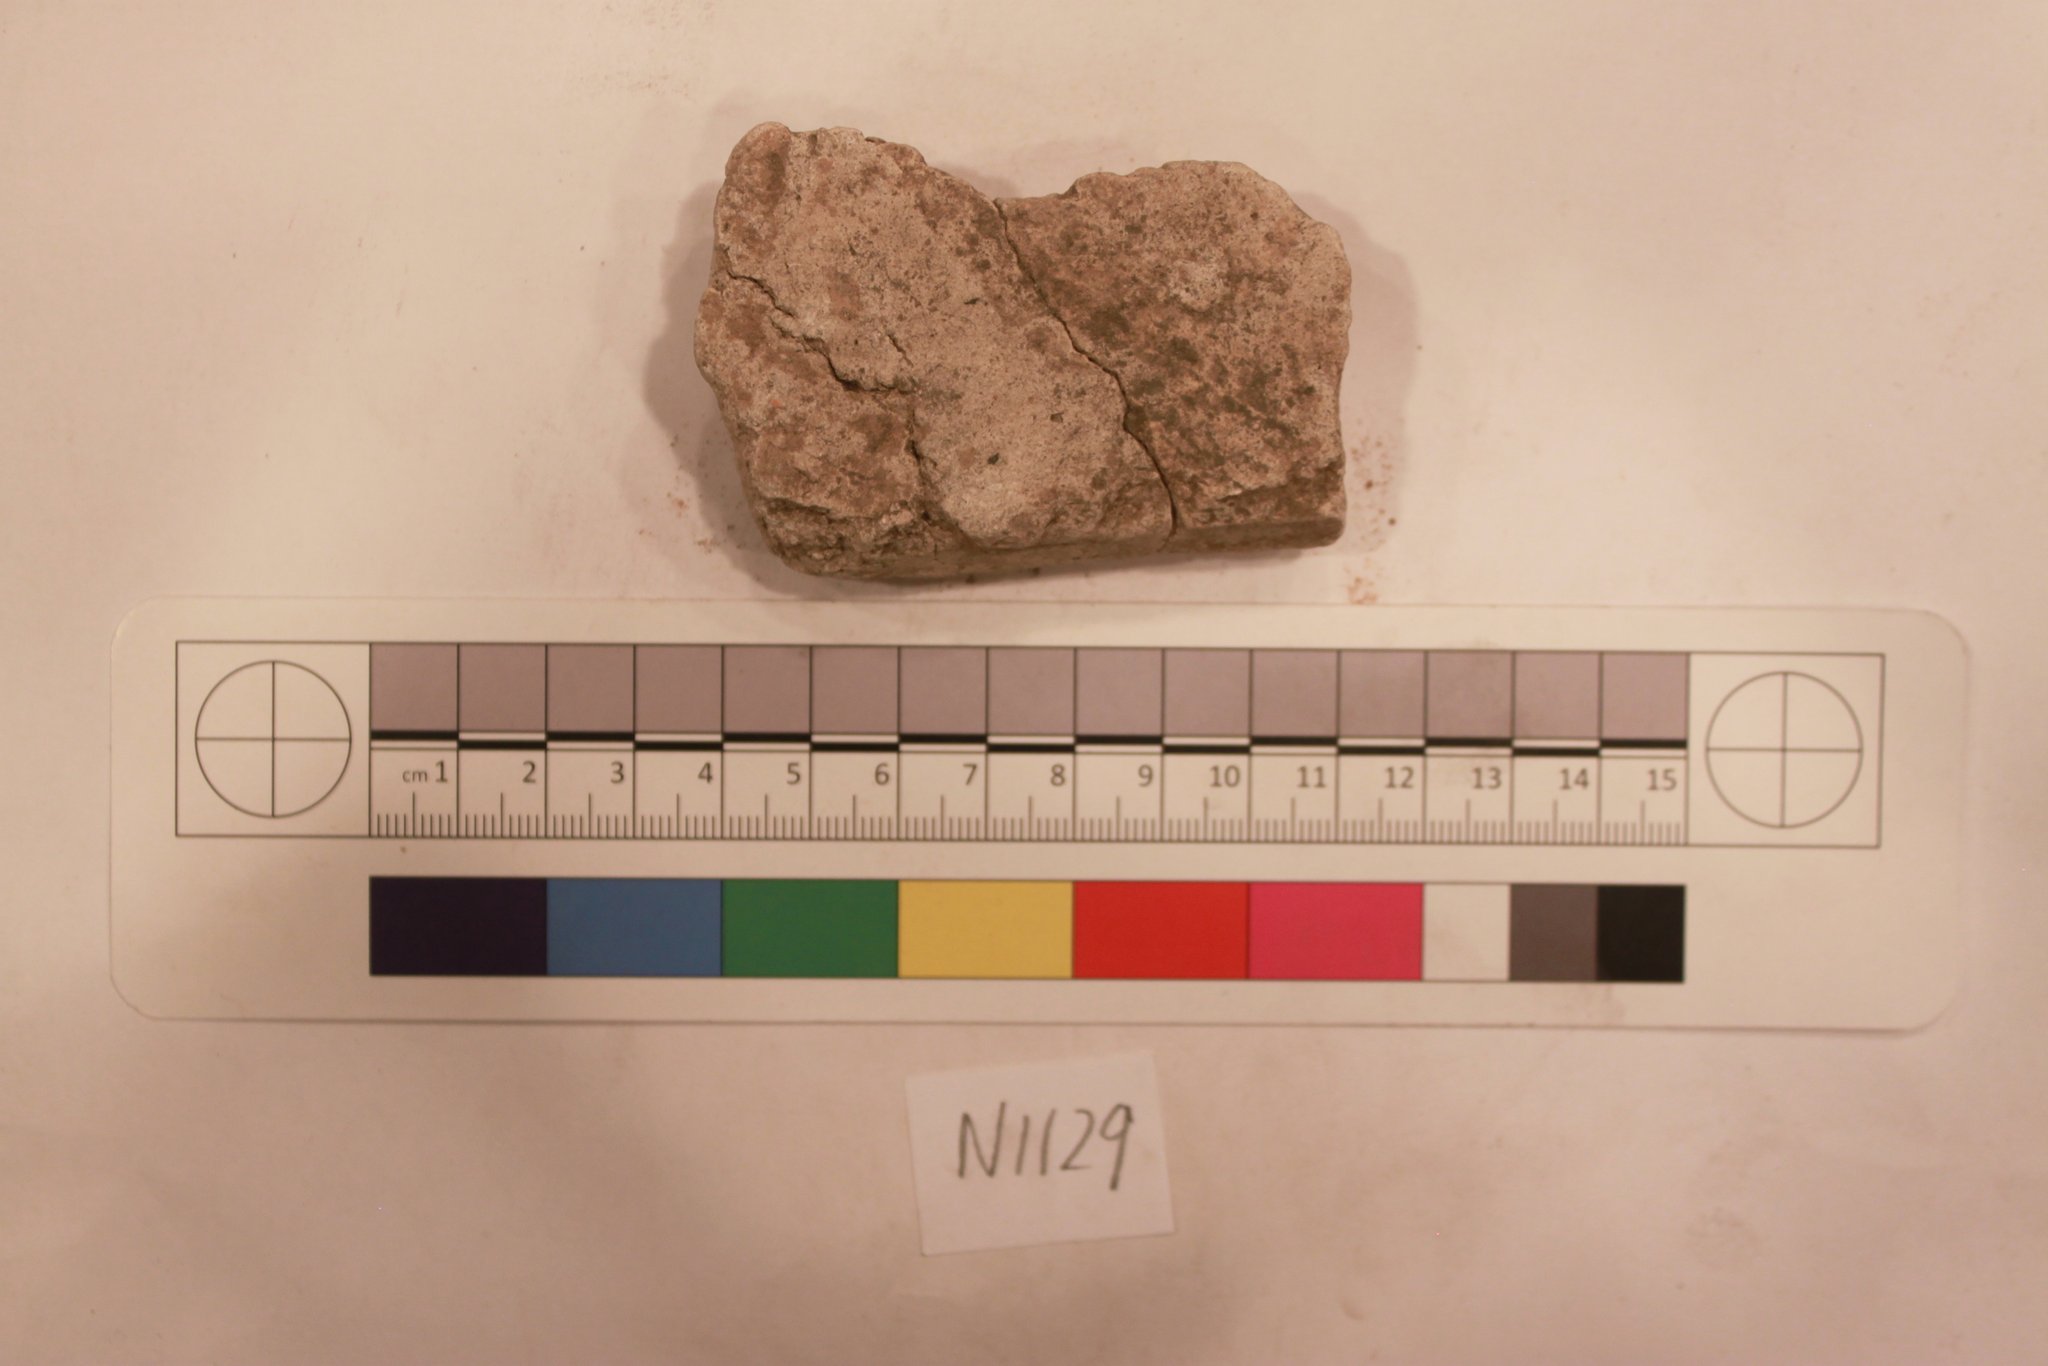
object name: fragment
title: Stucco Fragment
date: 701-1200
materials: plaster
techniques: carving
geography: iran